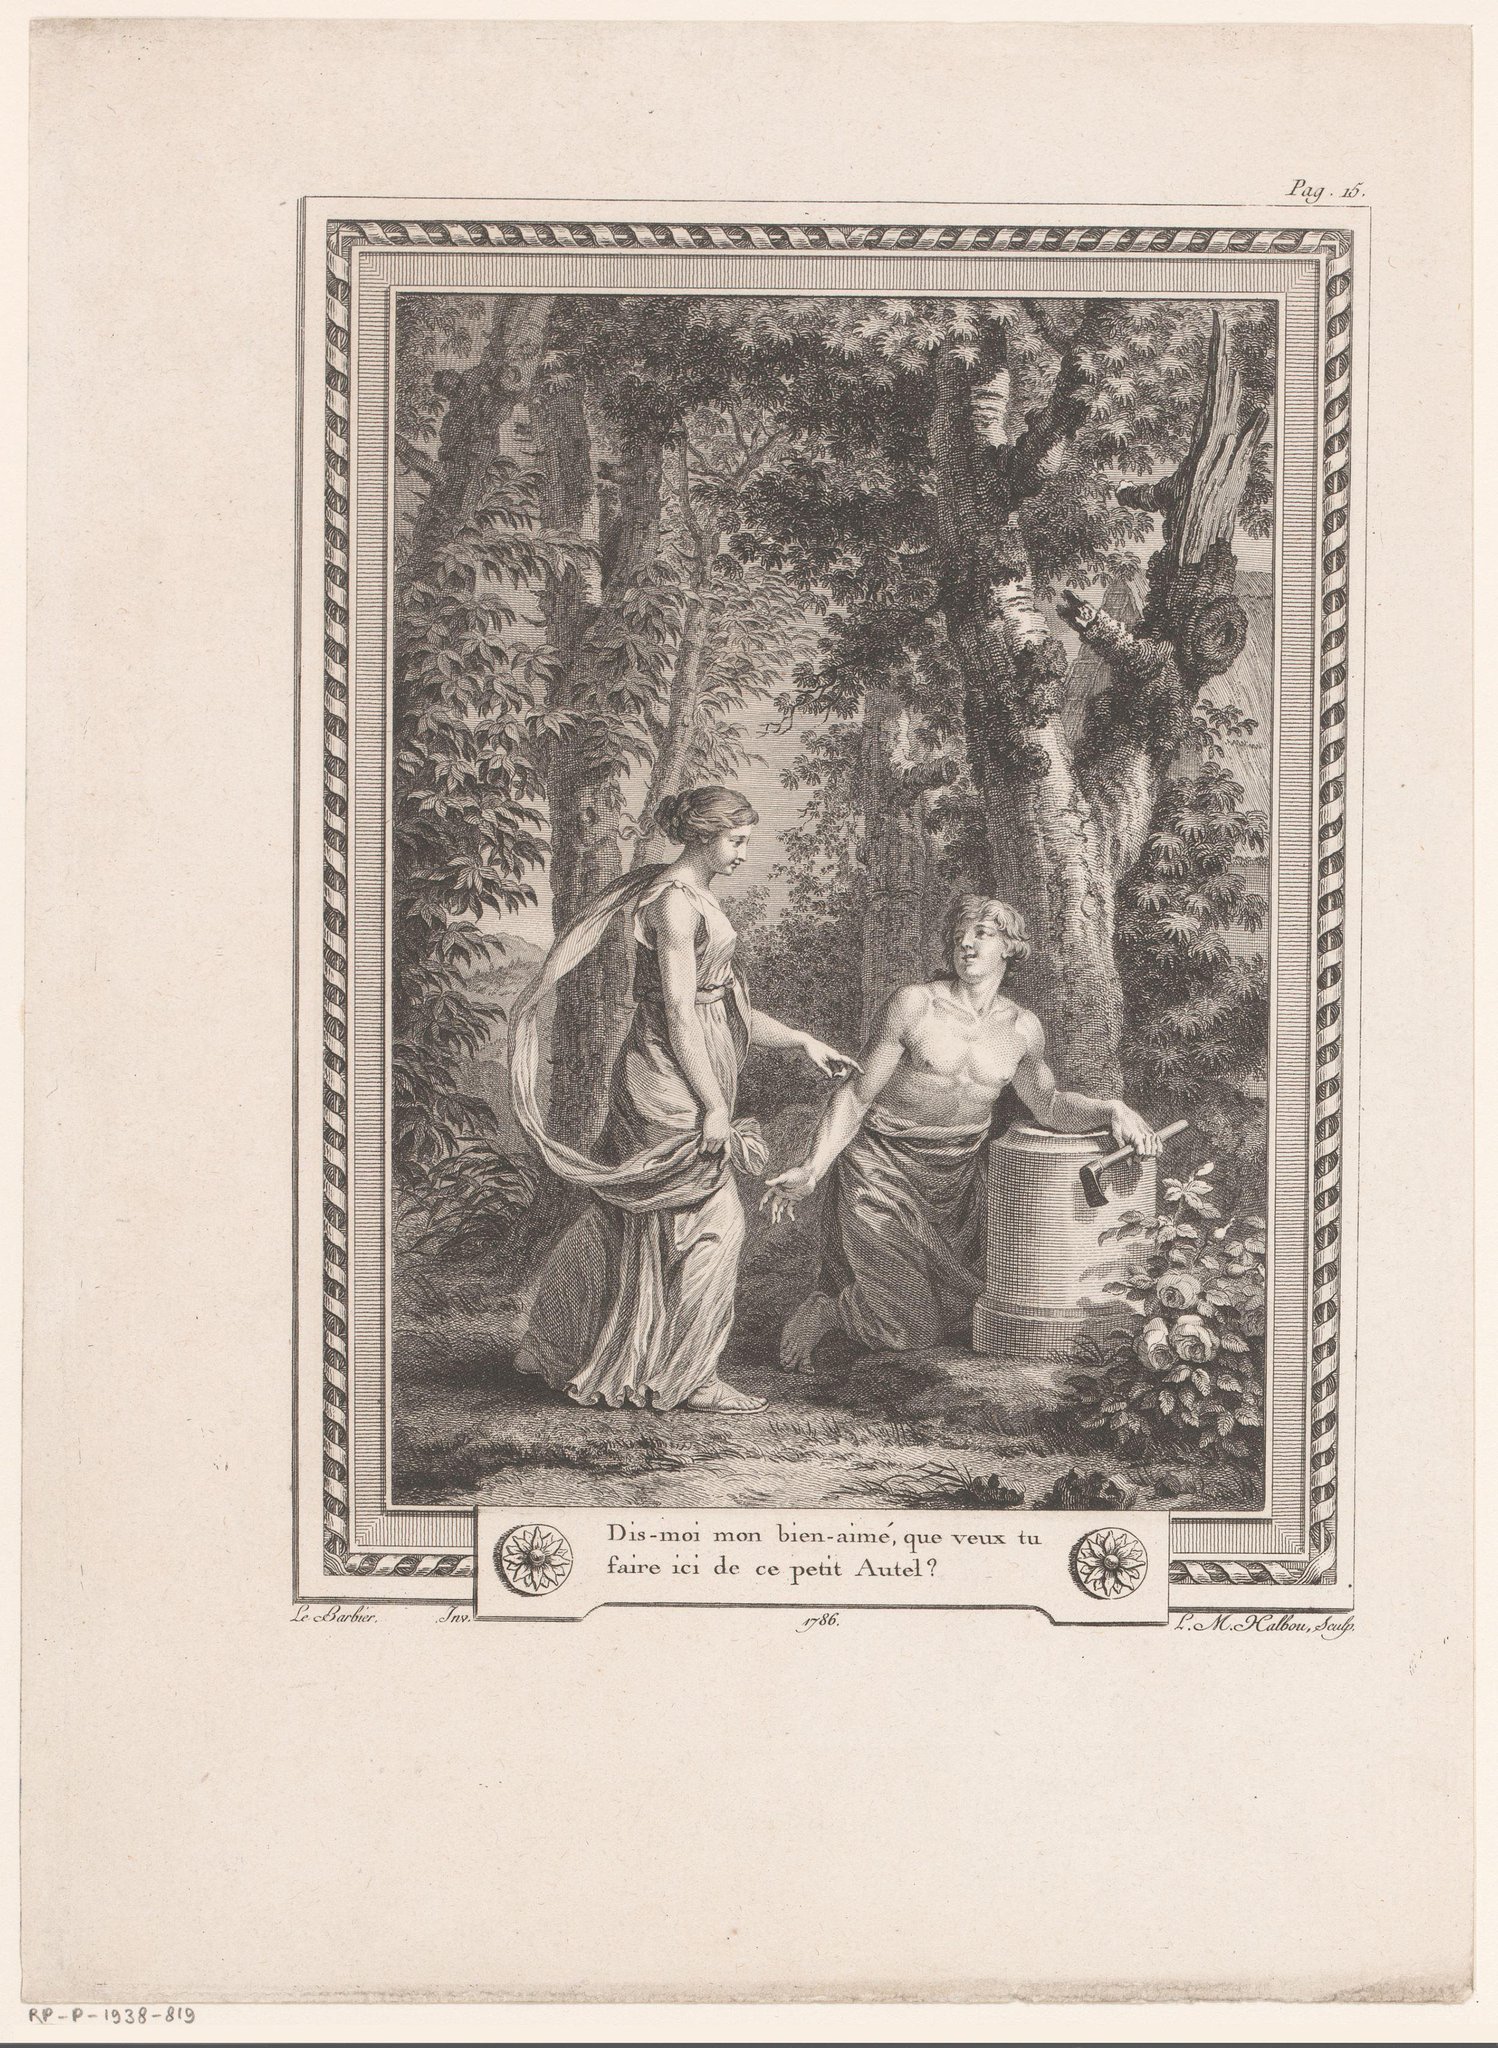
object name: print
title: Clymene en Damon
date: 1786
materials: paper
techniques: engraving, etching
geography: paris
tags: (story of) damon, friend of pythias (phintias), clymene, mother of phaethon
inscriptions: collector's mark: Lugt 2228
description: Prent uit: Oeuvres de Salomon Gessner. Parijs: Le Barbier, Veuve Hérissant & Barrois aîné, 1786-1793. Dit boek betreft een verzameling van de werken van Salomon Gessner, vertaald door Huber, Meister en Bruté de Loirelle en gepubliceerd in drie delen.